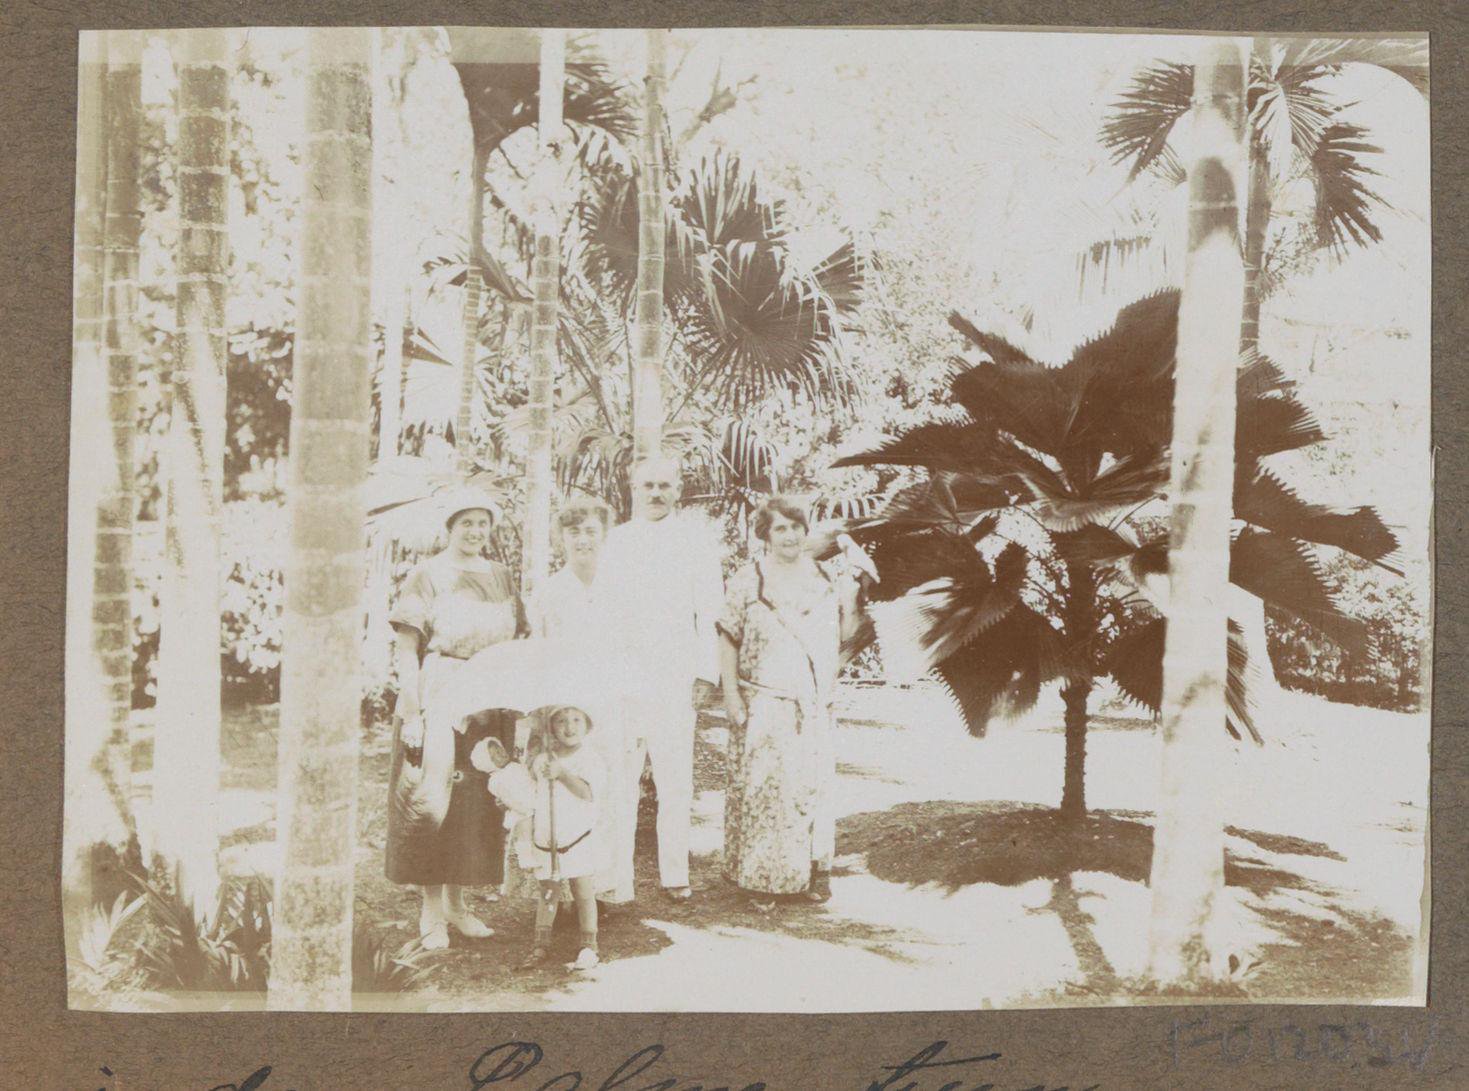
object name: photograph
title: Op Soeki-baka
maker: Anonymous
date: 1920-1930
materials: photographic support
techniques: daylight paper print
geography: suriname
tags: adult woman, adult man, suriname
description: Onderdeel van fotoalbum van een onbekende Nederlandse familie met opnames van Suriname, Europa en Nederlands-Indië.